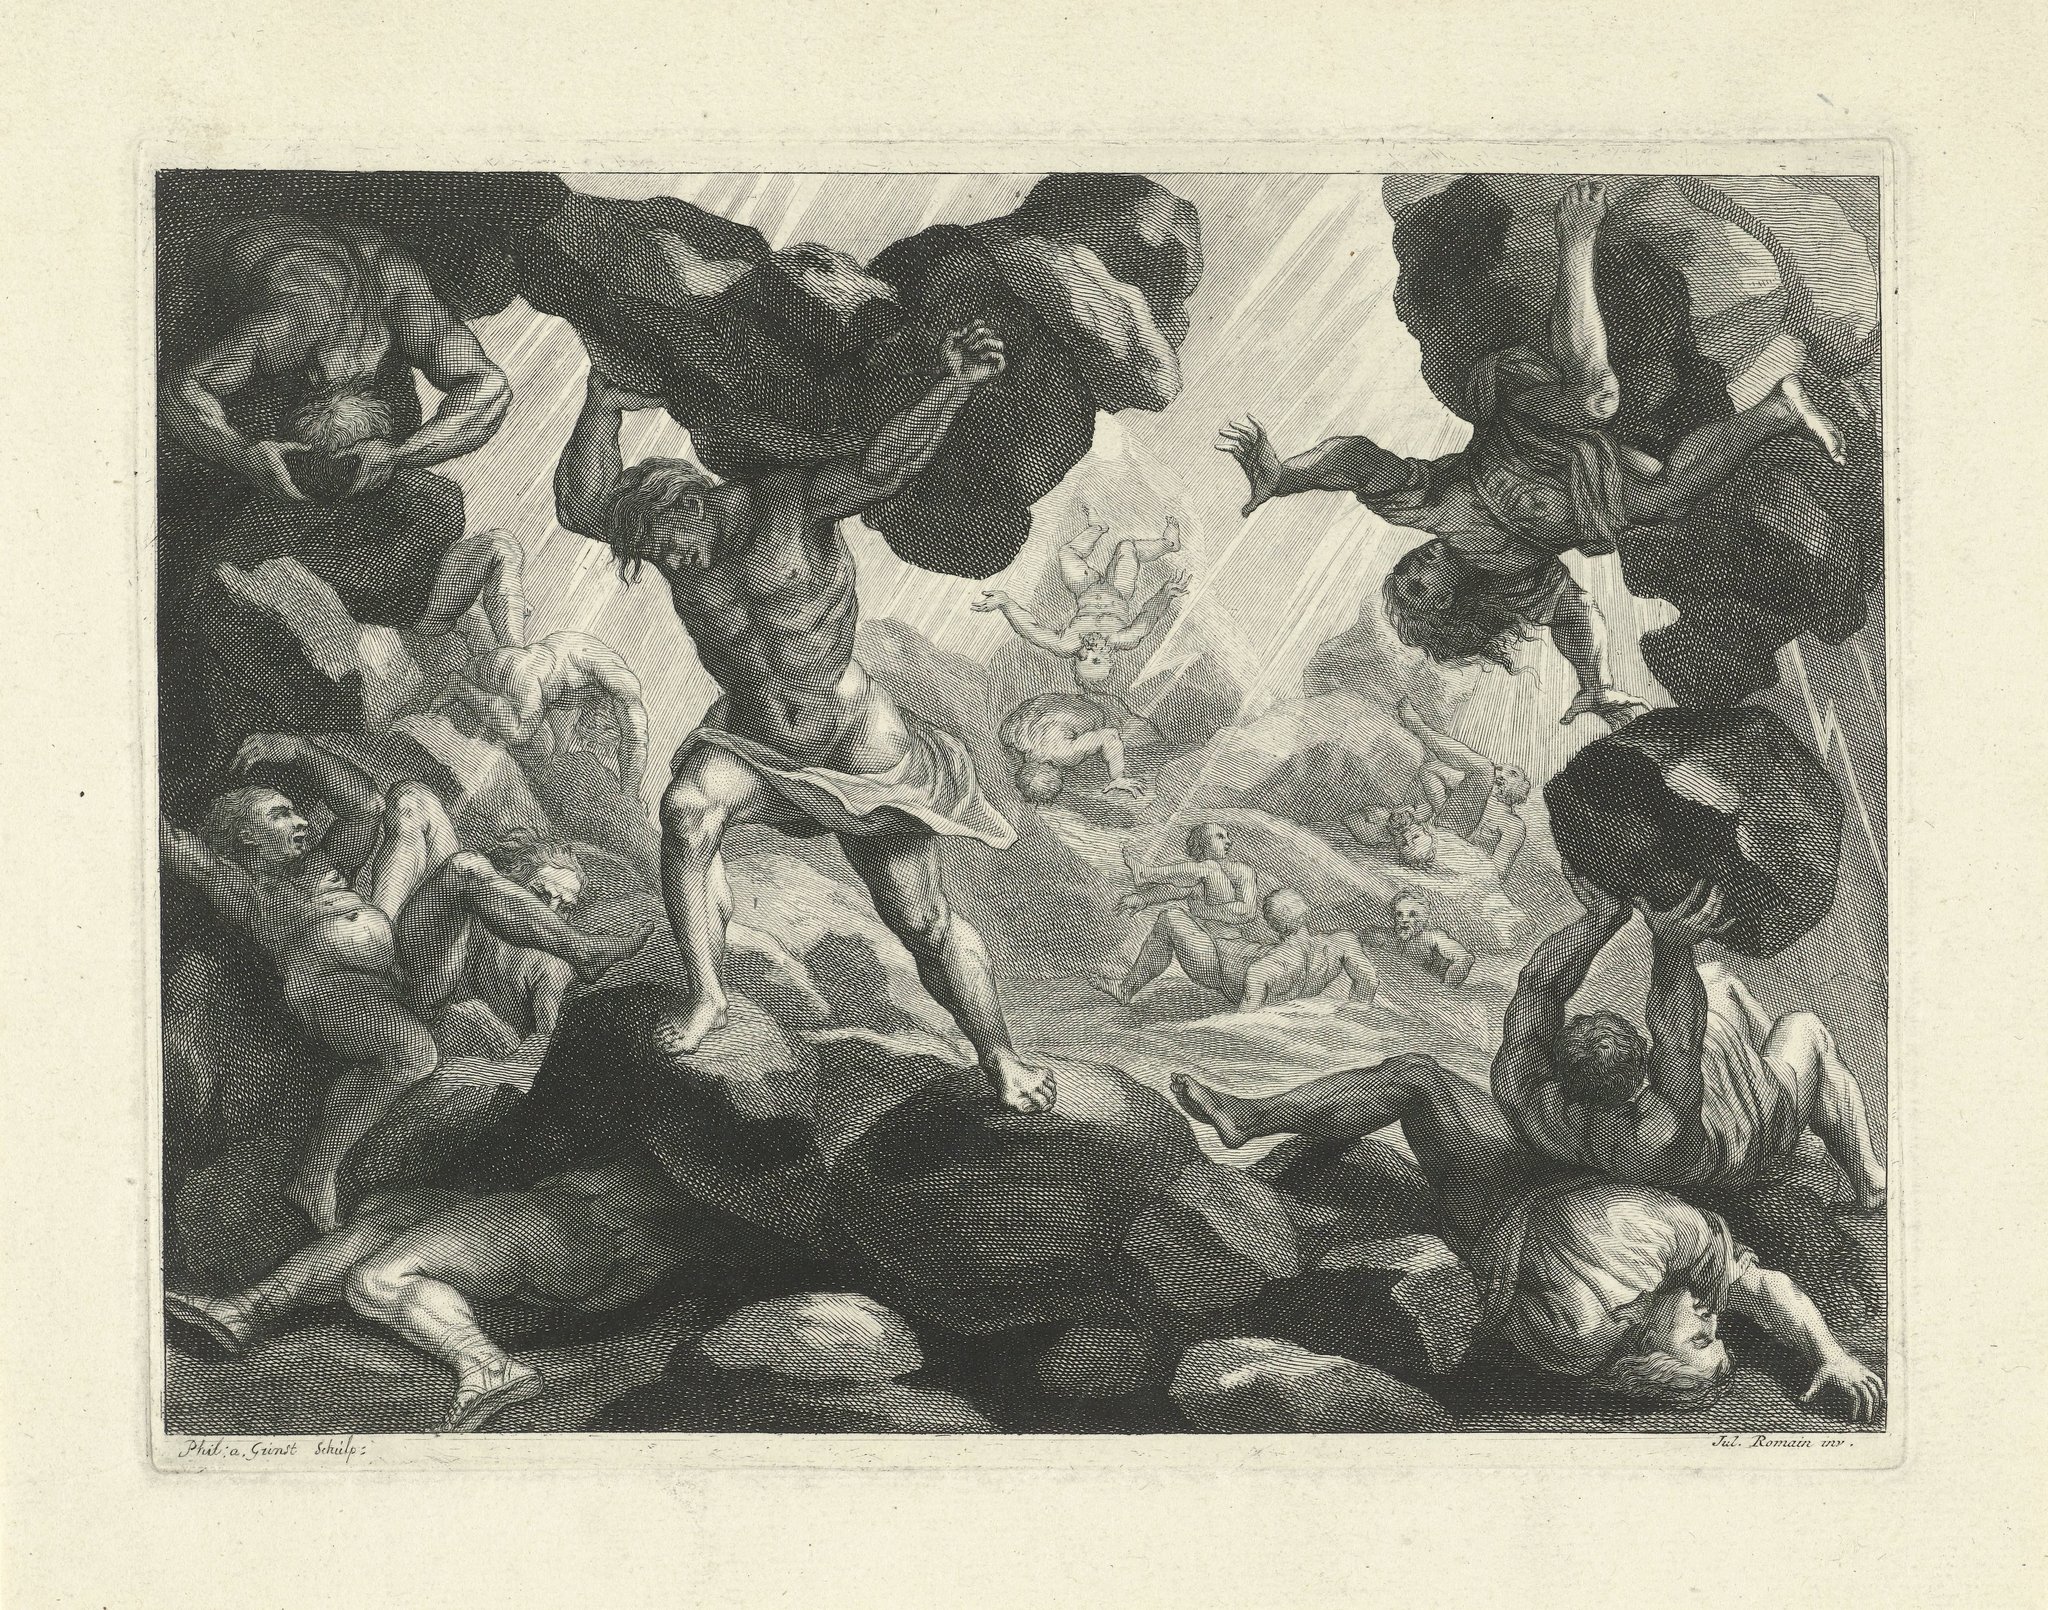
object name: print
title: Nederlaag van de titanen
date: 1685-1732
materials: paper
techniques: engraving, etching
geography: amsterdam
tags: war of the titans against jupiter and allies: titanomachy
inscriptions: collector's mark: Lugt 2228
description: De titanen trachten de berg Olympus te veroveren, maar worden door Jupiter en de andere goden teruggeslagen en met bliksem en stenen bekogeld. De titanen vallen uit de hemel en komen terecht in Tartarus, de onderwereld.